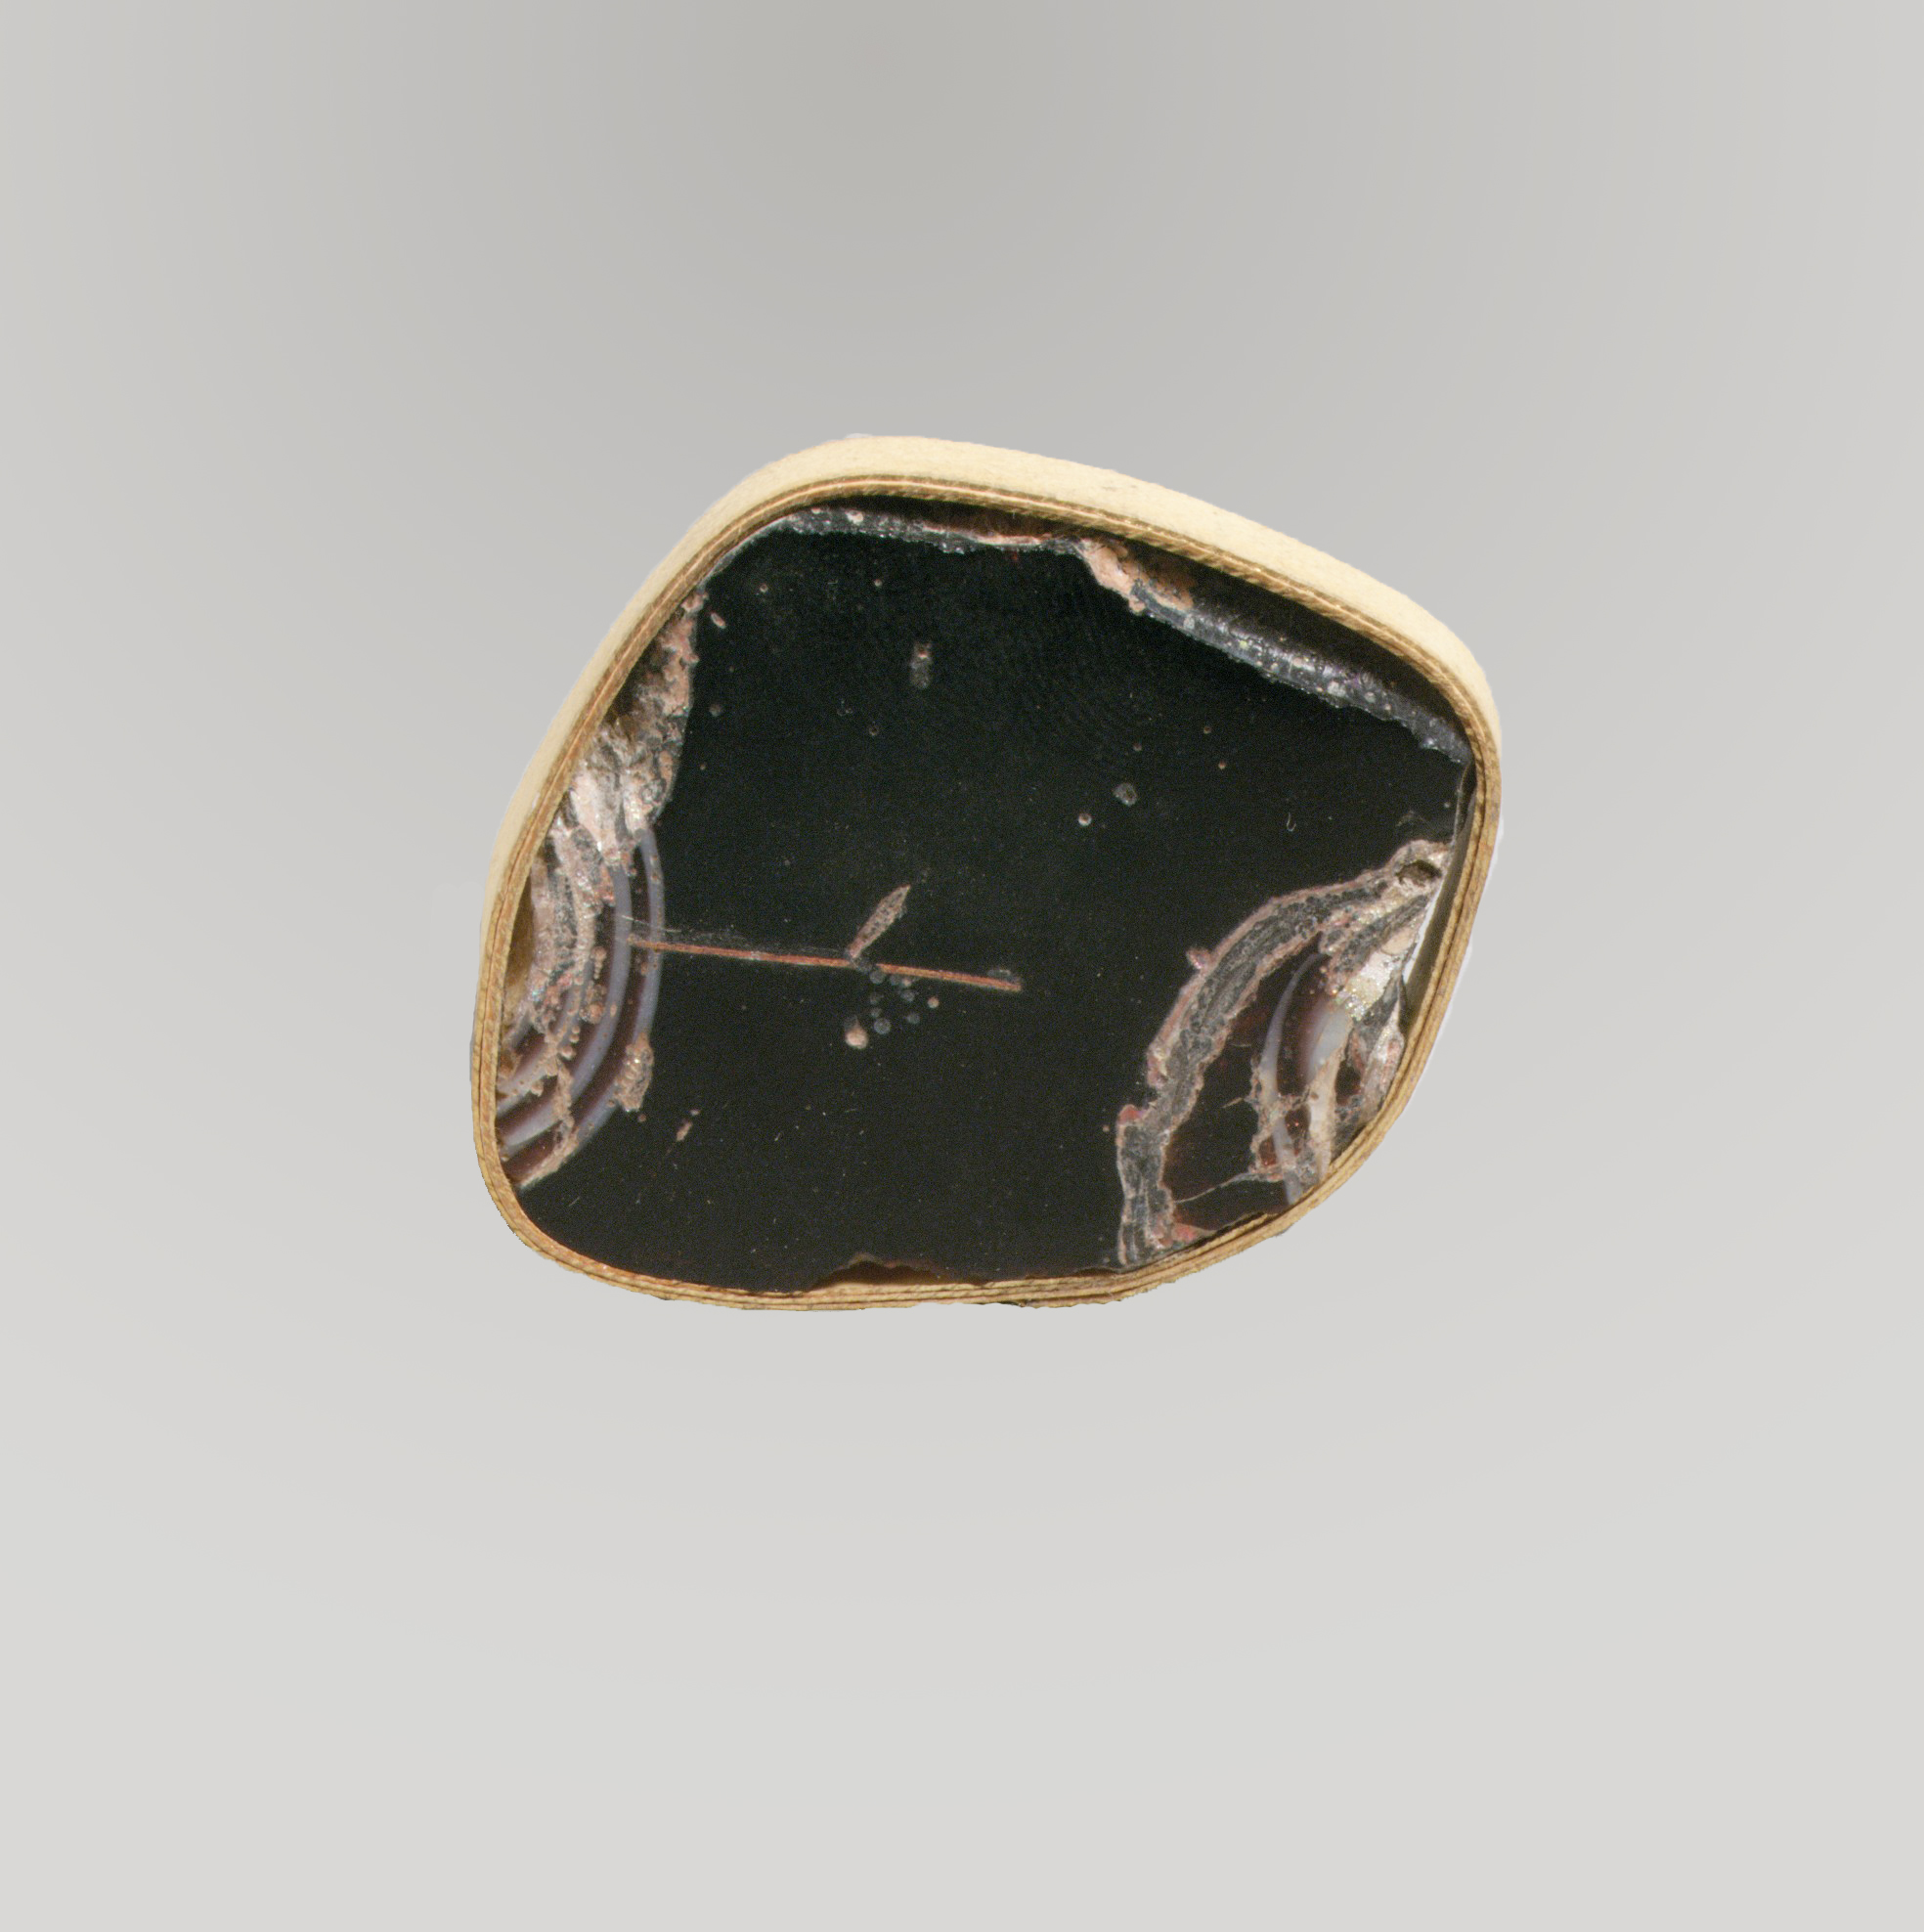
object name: fragment, mosaic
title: Glass mosaic inlay fragment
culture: roman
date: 34 BCE-33 CE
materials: glass